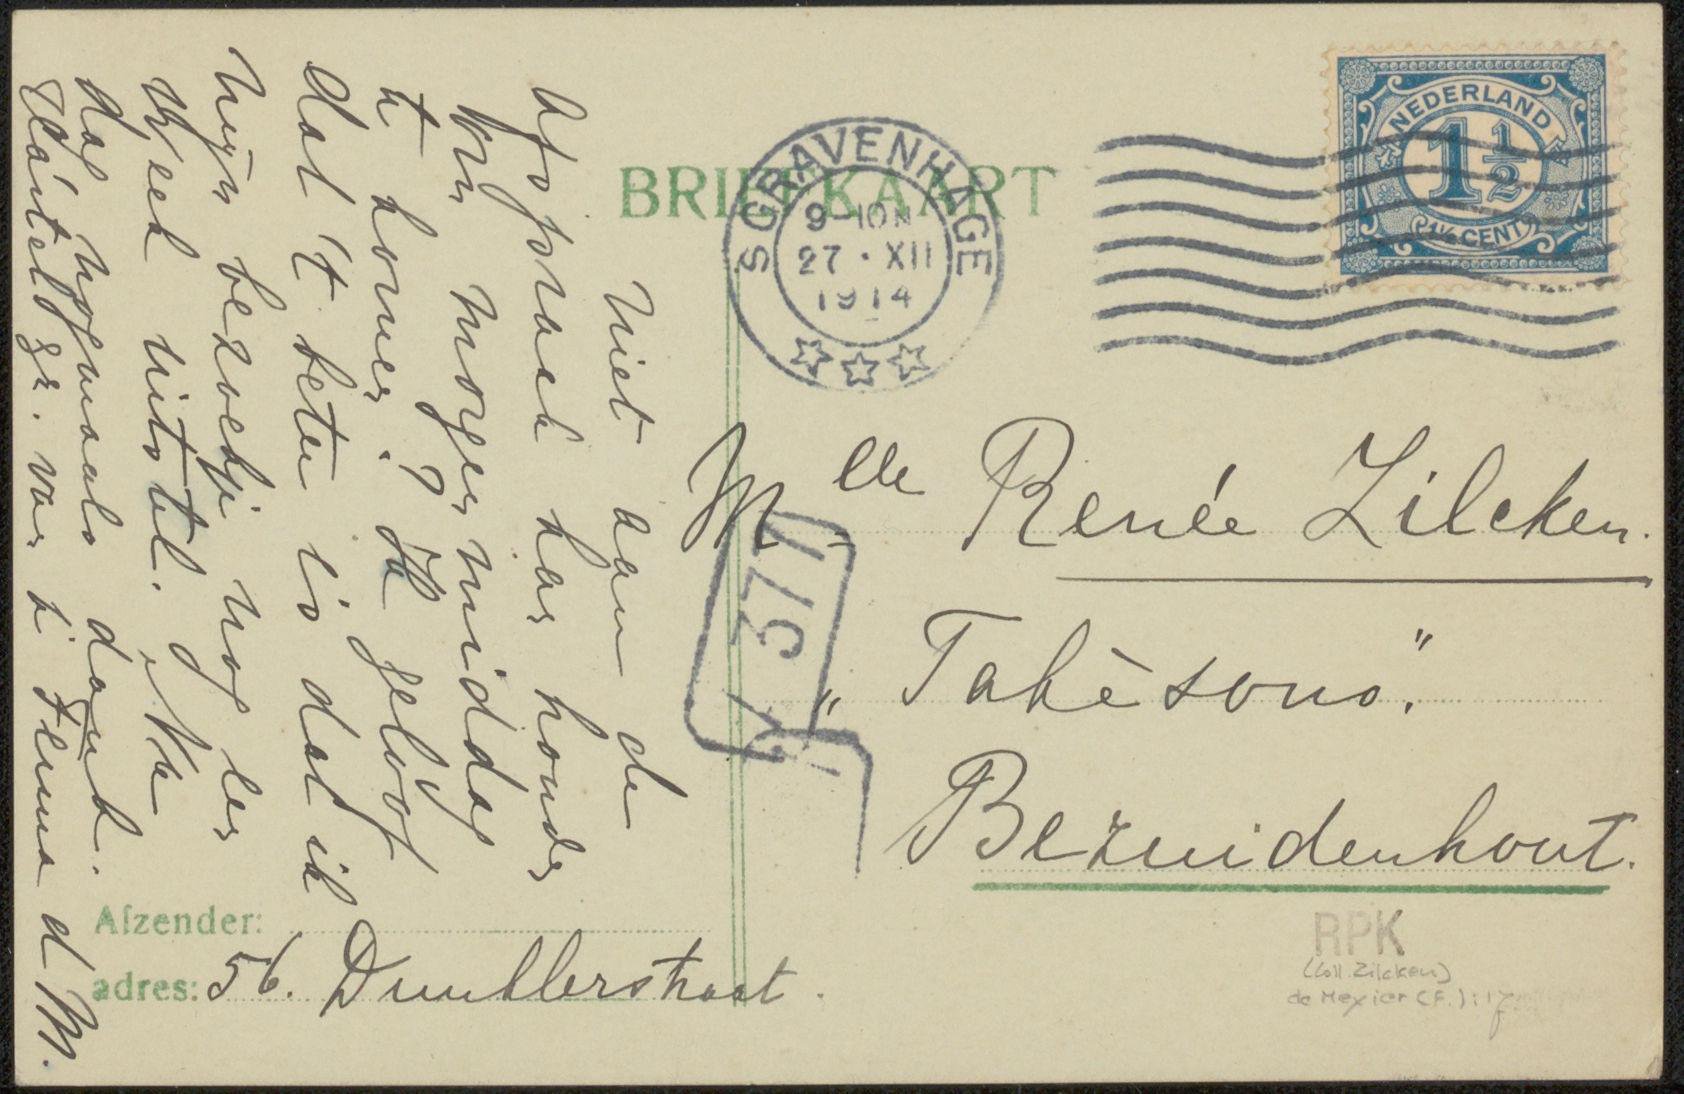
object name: postcard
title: Briefkaart aan Renée Hélène Laure Zilcken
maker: fenna de meyier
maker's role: onderwijzer, schrijver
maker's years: 1874-1943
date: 1914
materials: cardboard, ink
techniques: pen, writing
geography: the hague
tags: voorburg, print maker, renée hélène laure zilcken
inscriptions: collector's mark: ‘RPK’